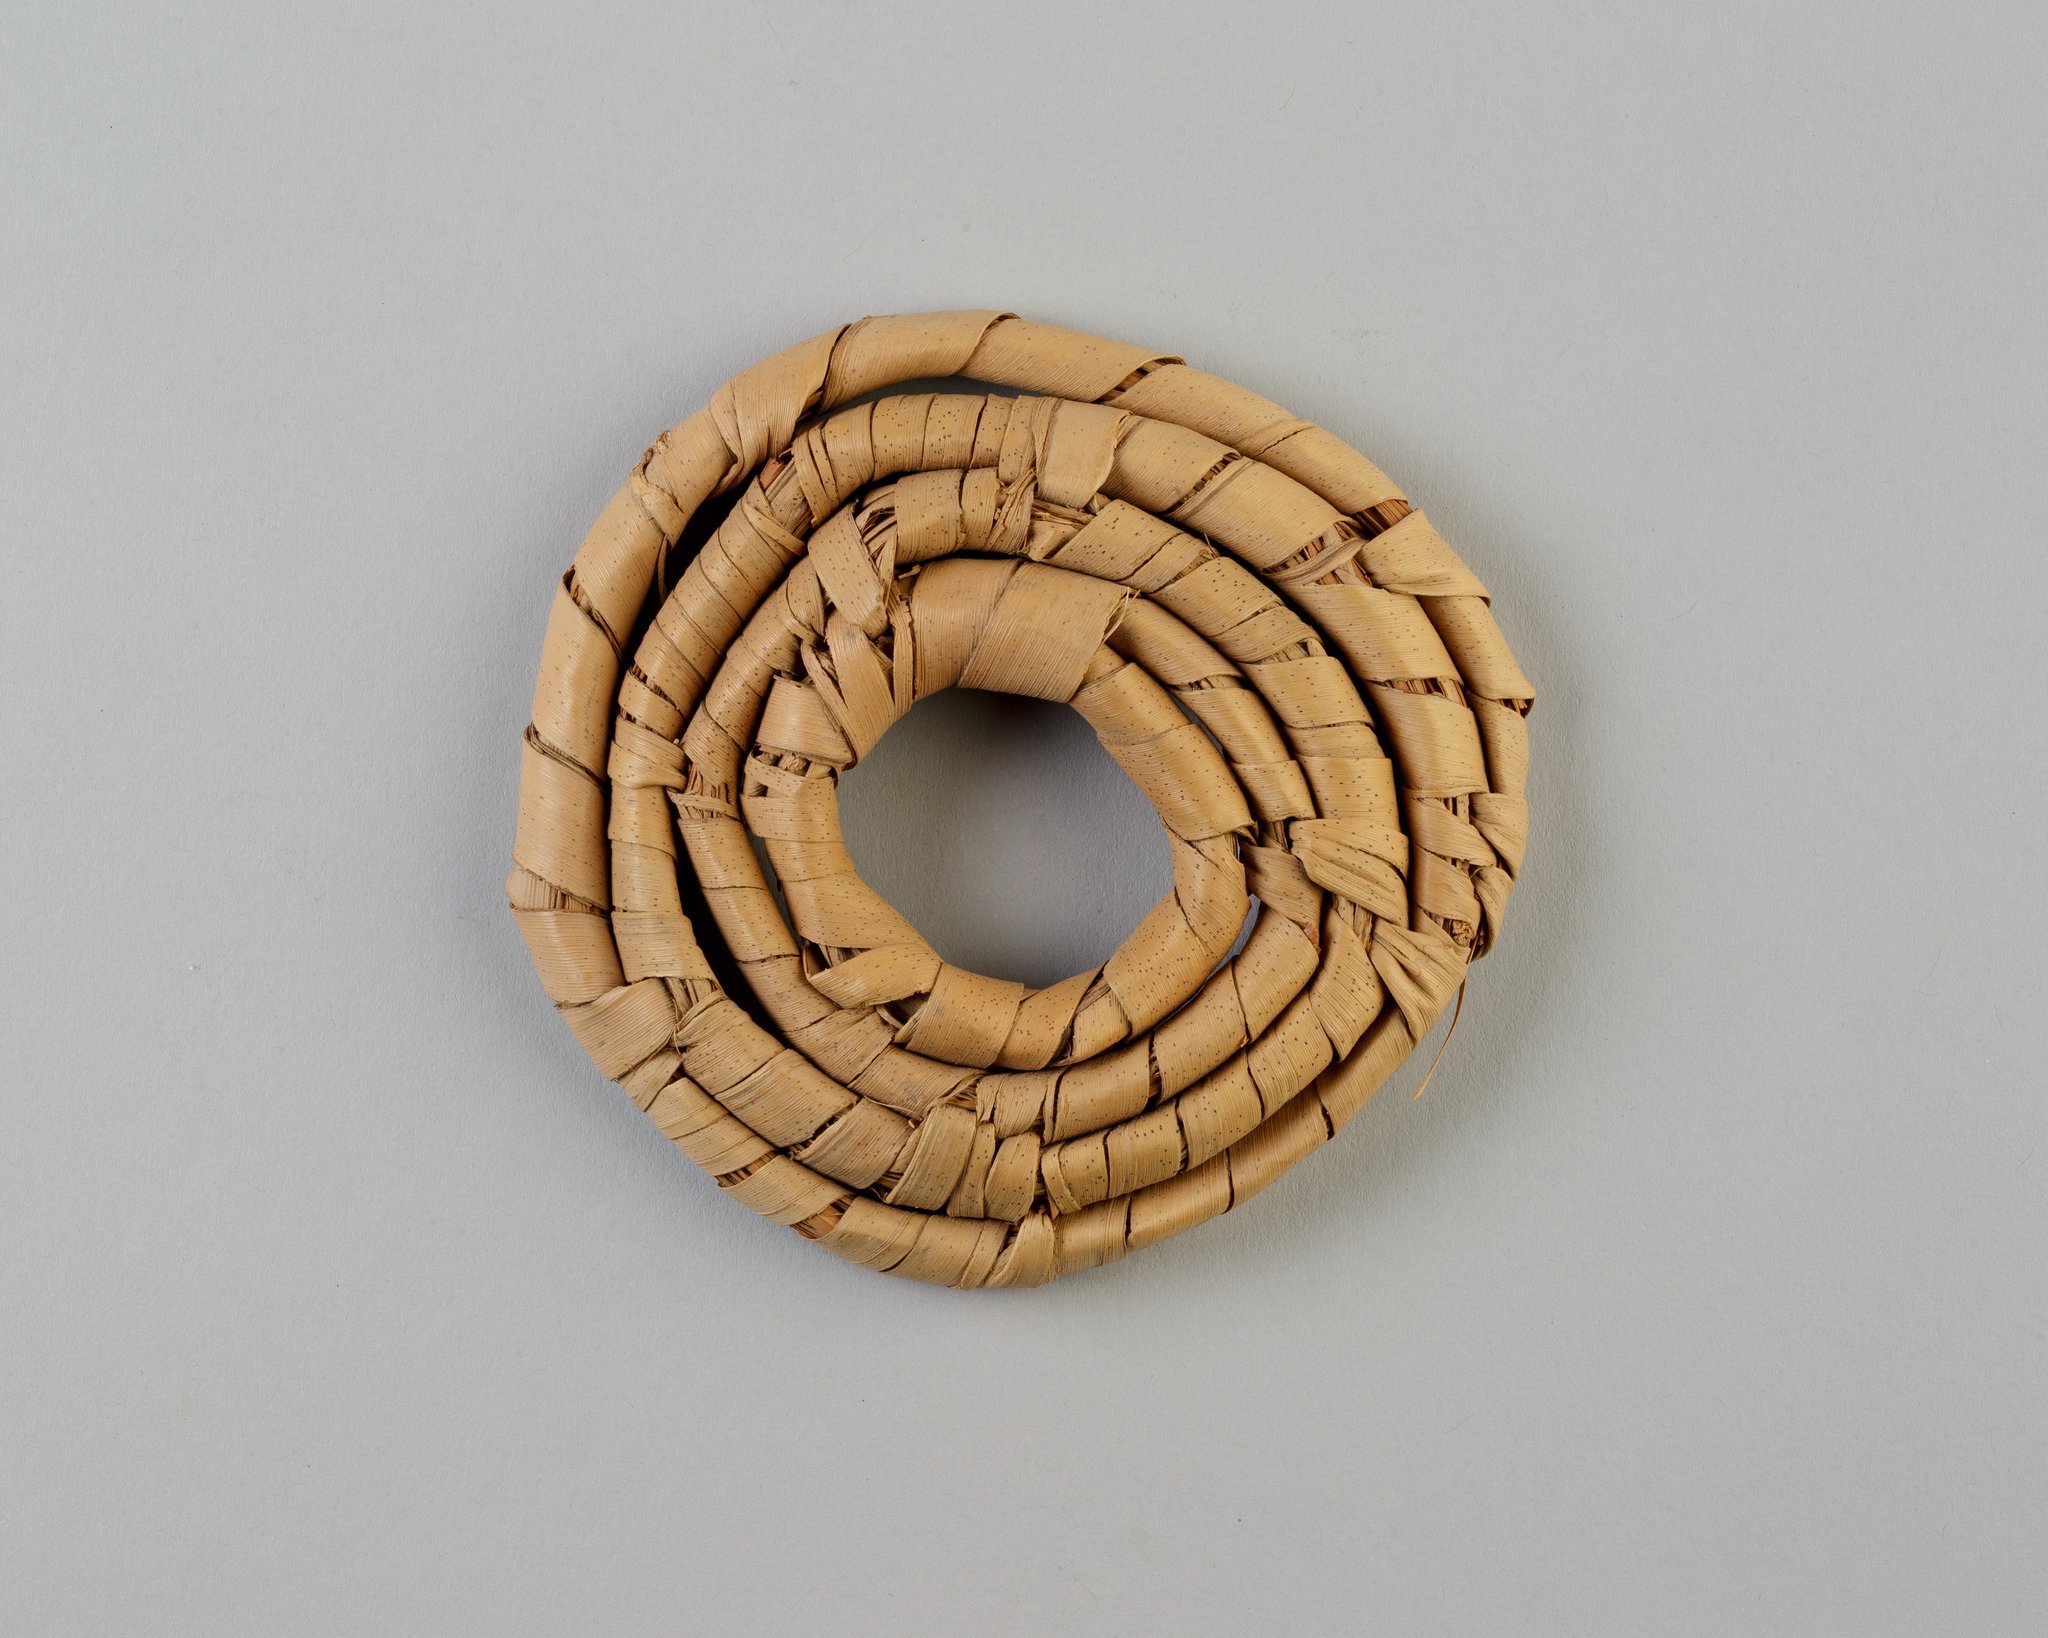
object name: basketry, model, senenmut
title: Pot Stand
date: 1479-1458 BCE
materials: leaf, fiber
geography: egypt